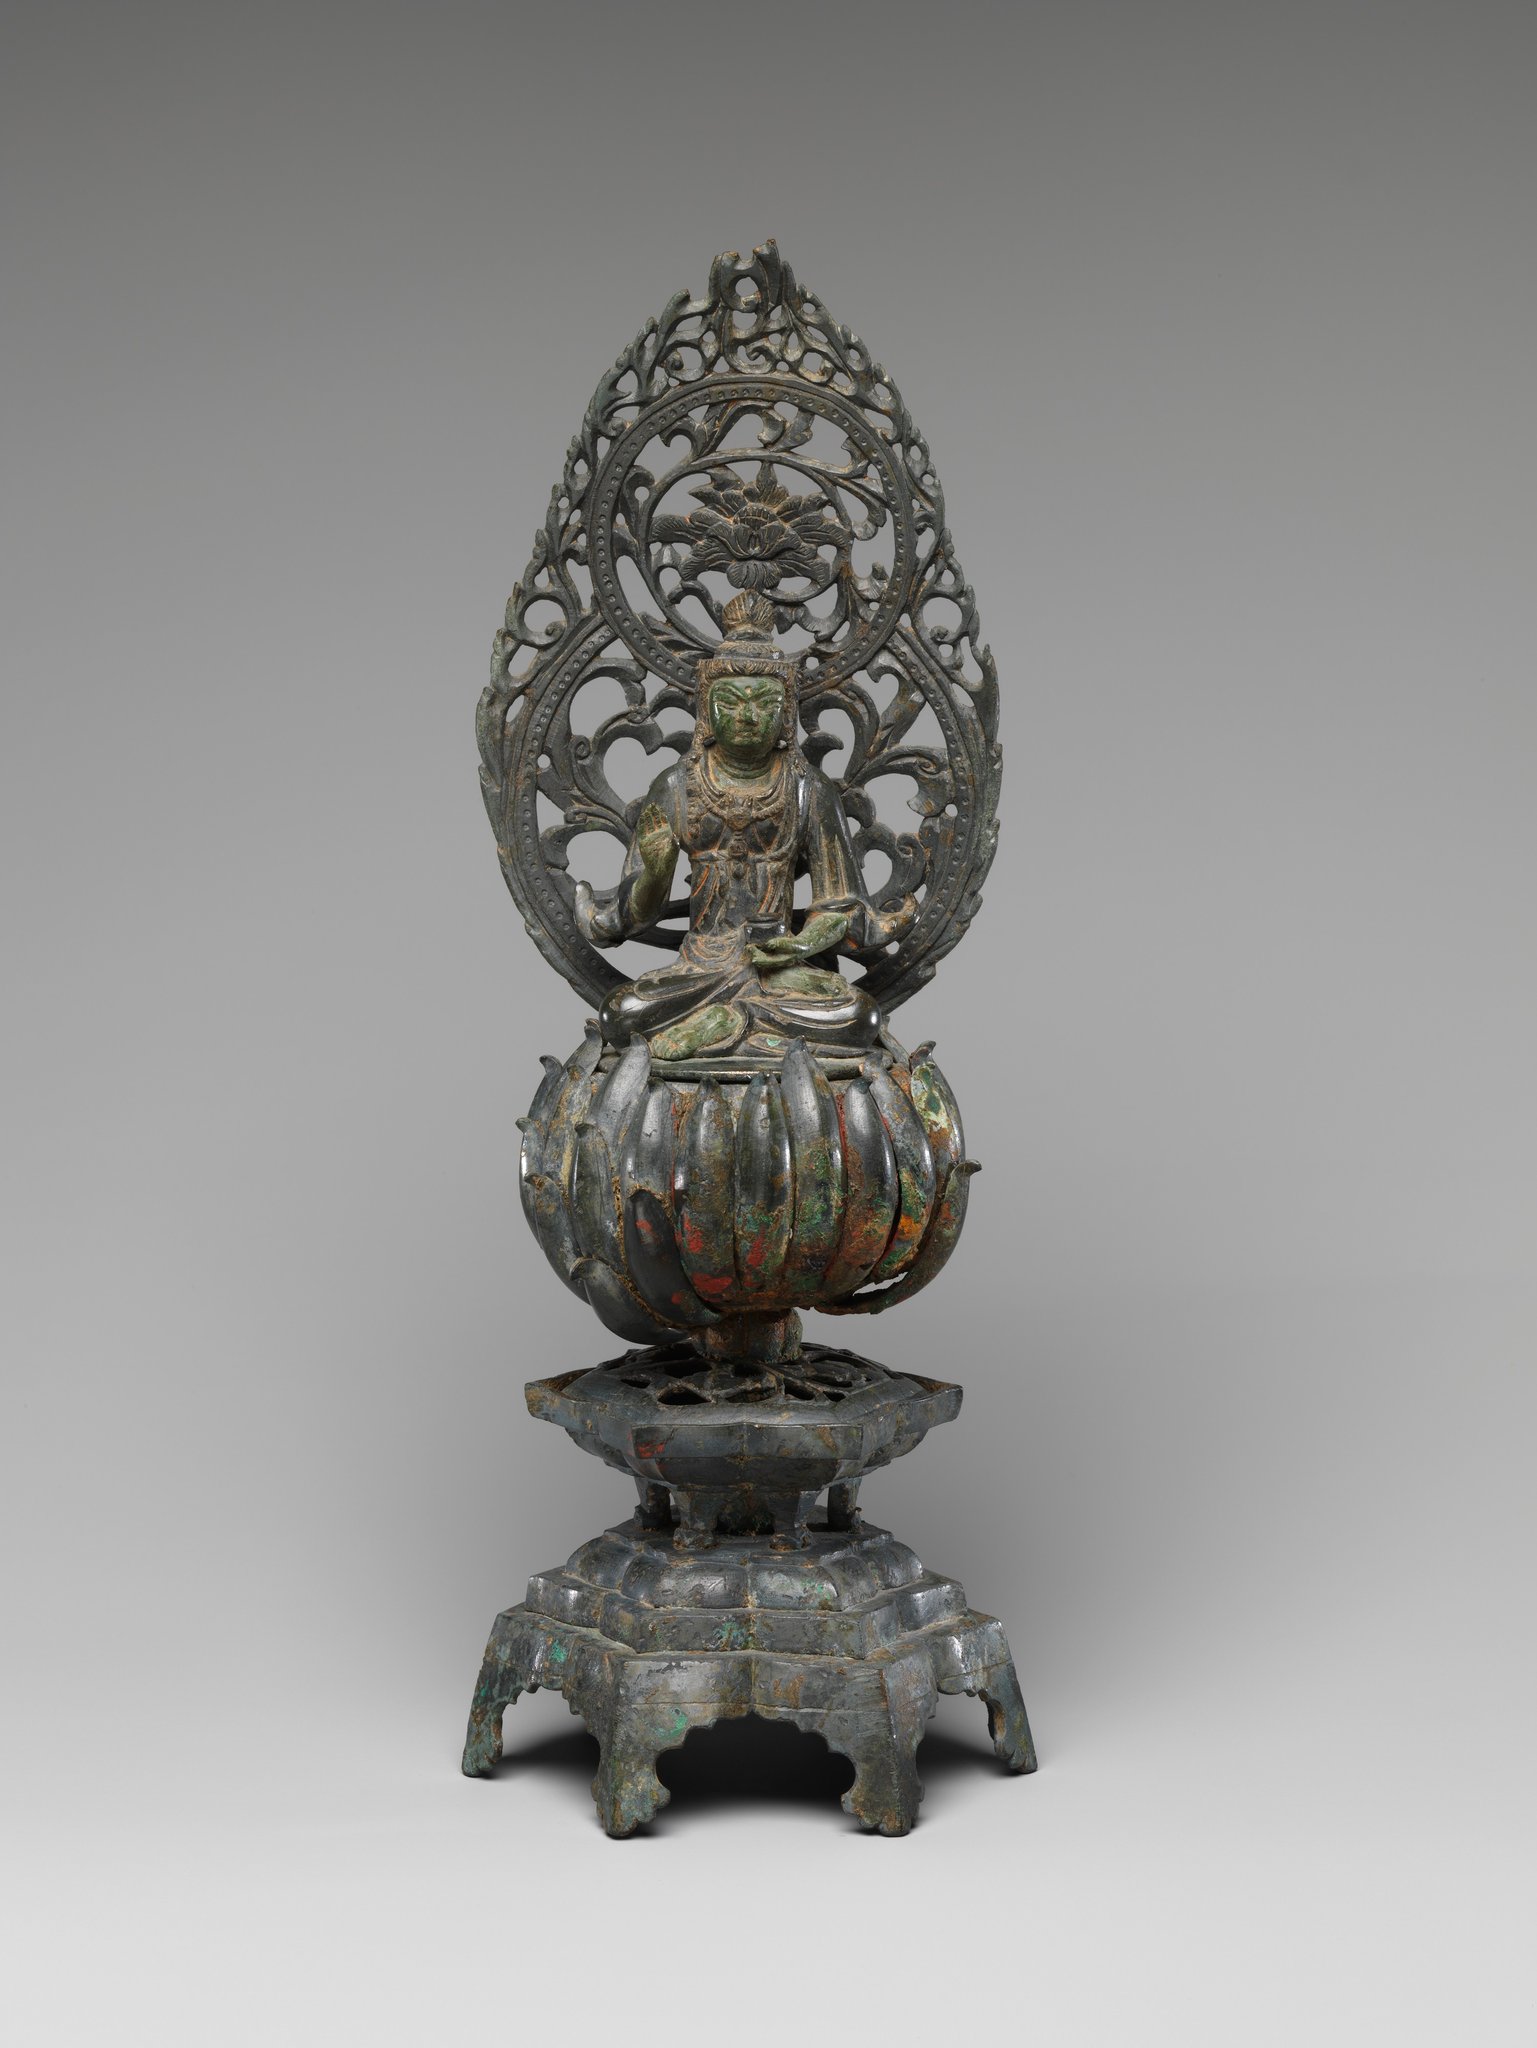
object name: statuette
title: Bodhisattva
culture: chinese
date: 901-1000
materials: bronze, wax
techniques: casting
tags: lotuses,buddhism,bodhisattvas